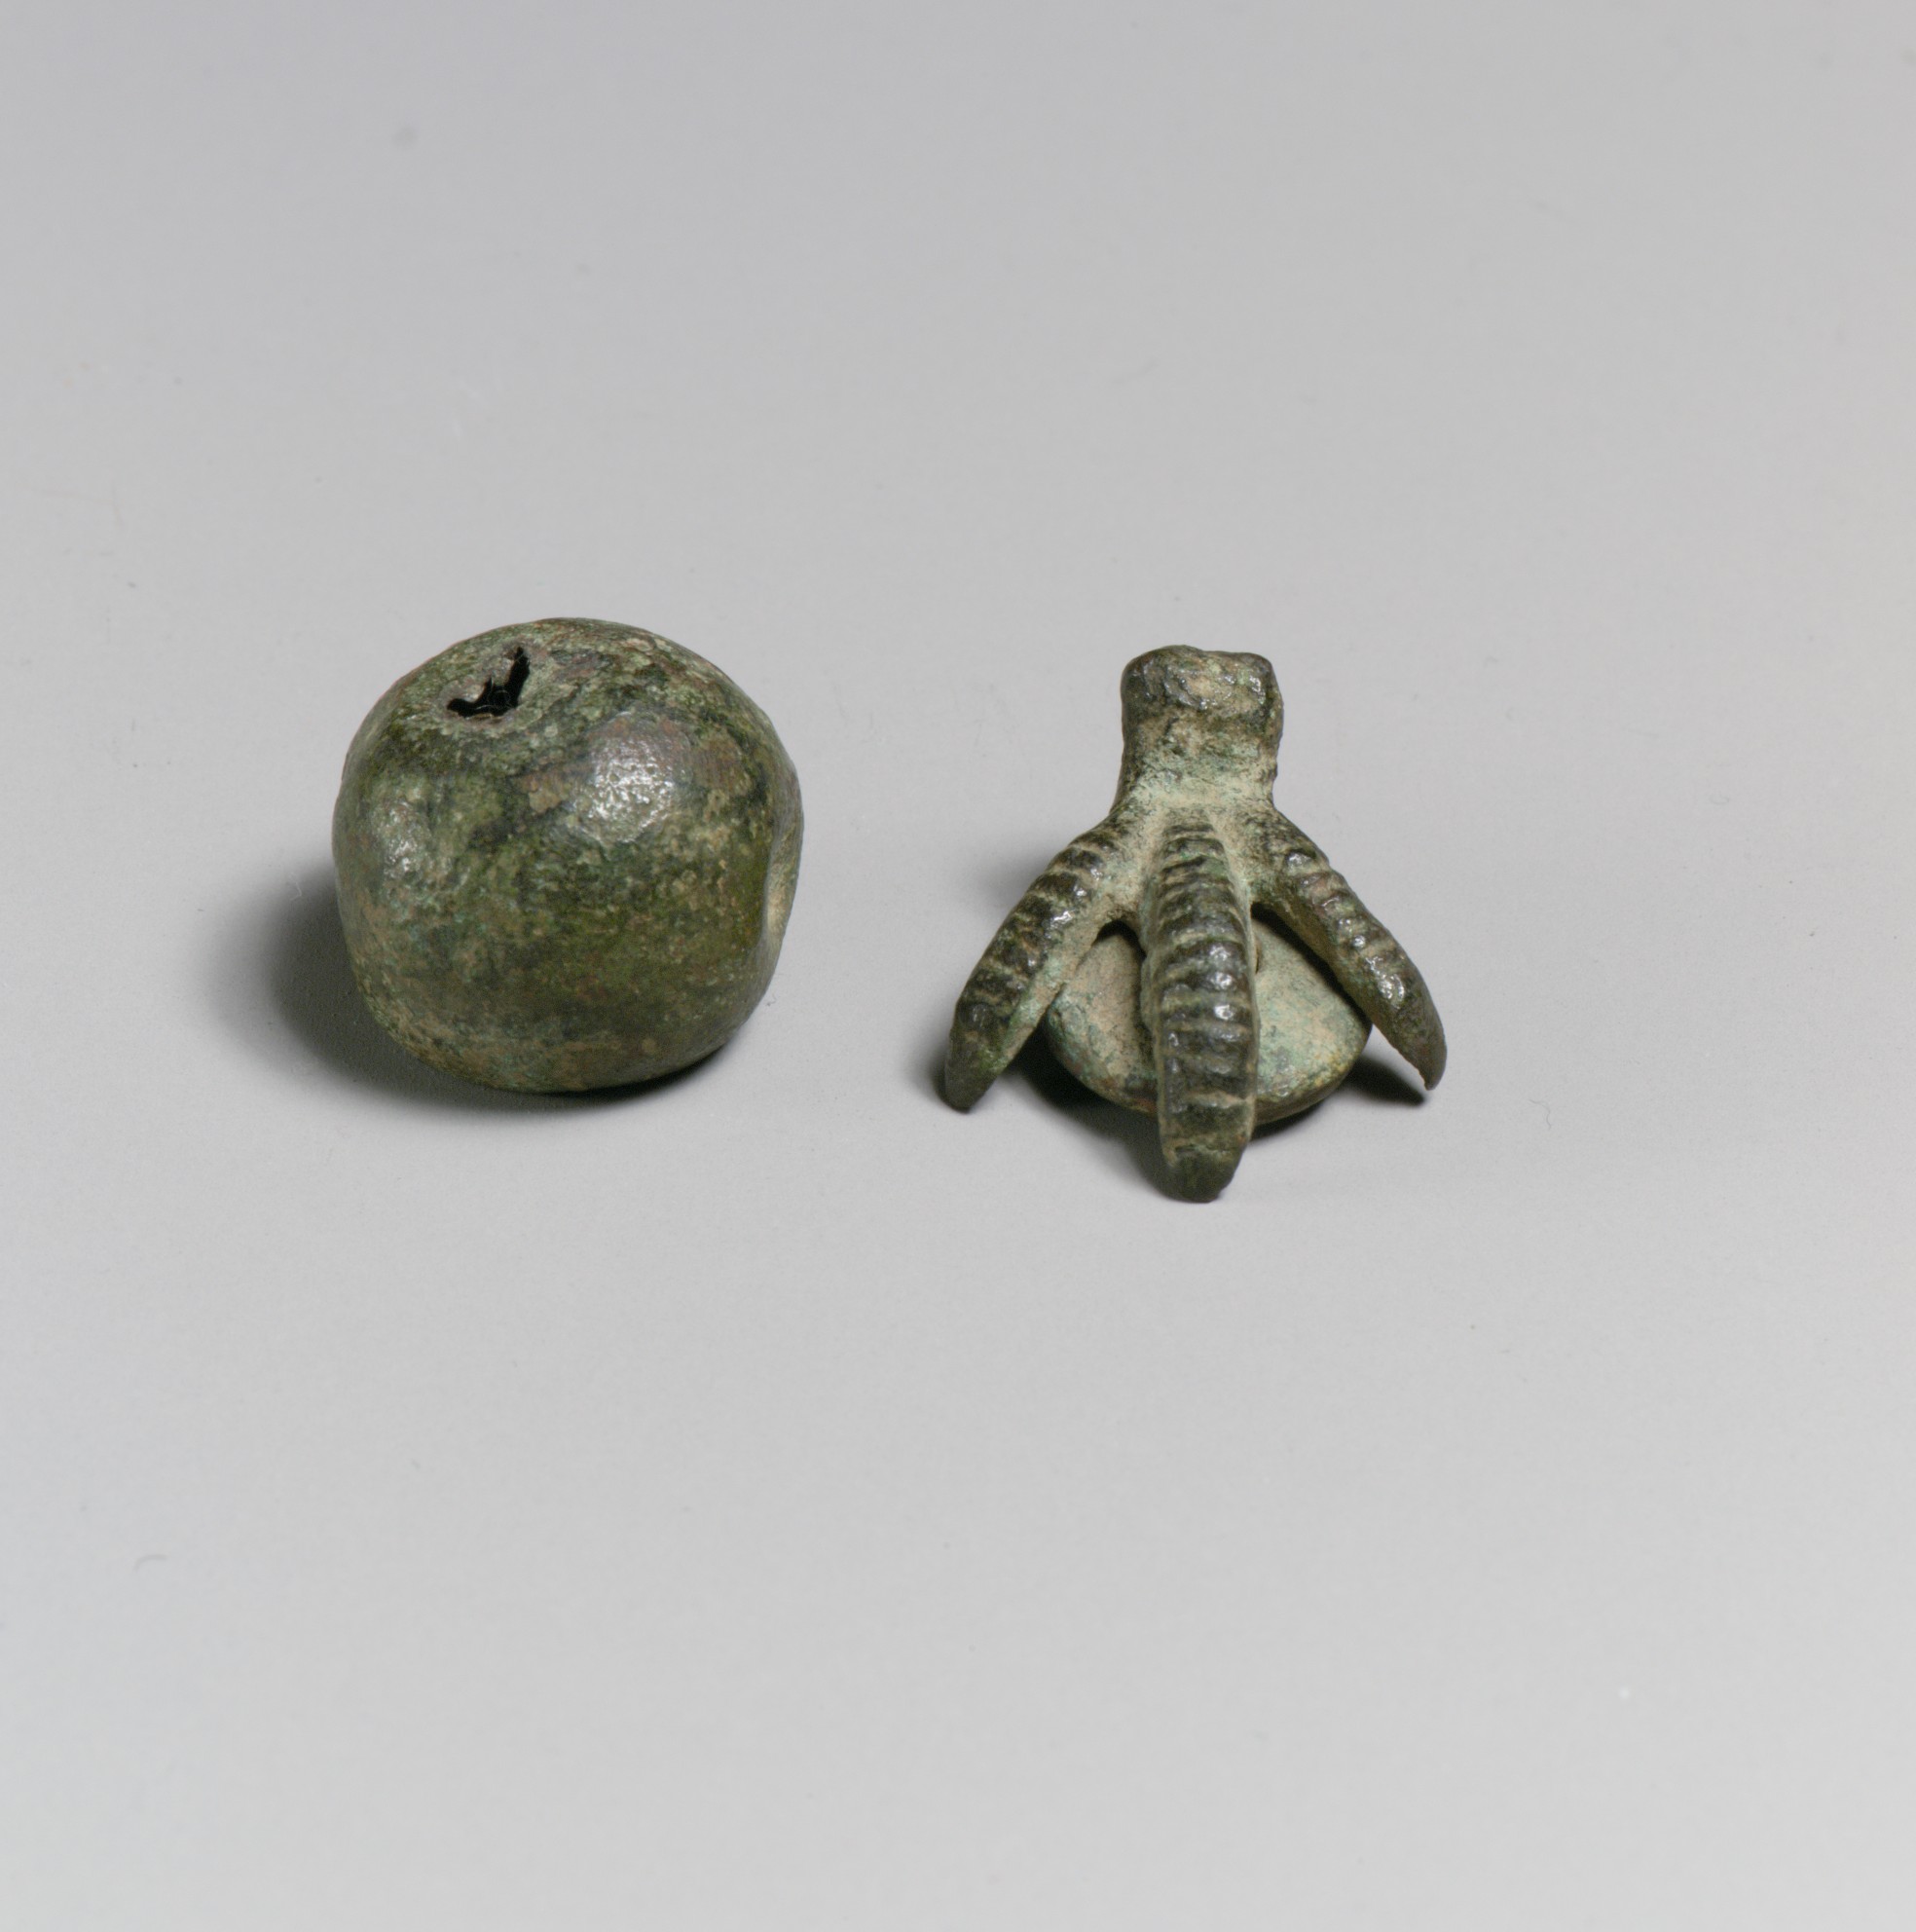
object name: vase, covered with bird's claw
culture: italic or roman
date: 301-400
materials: bronze